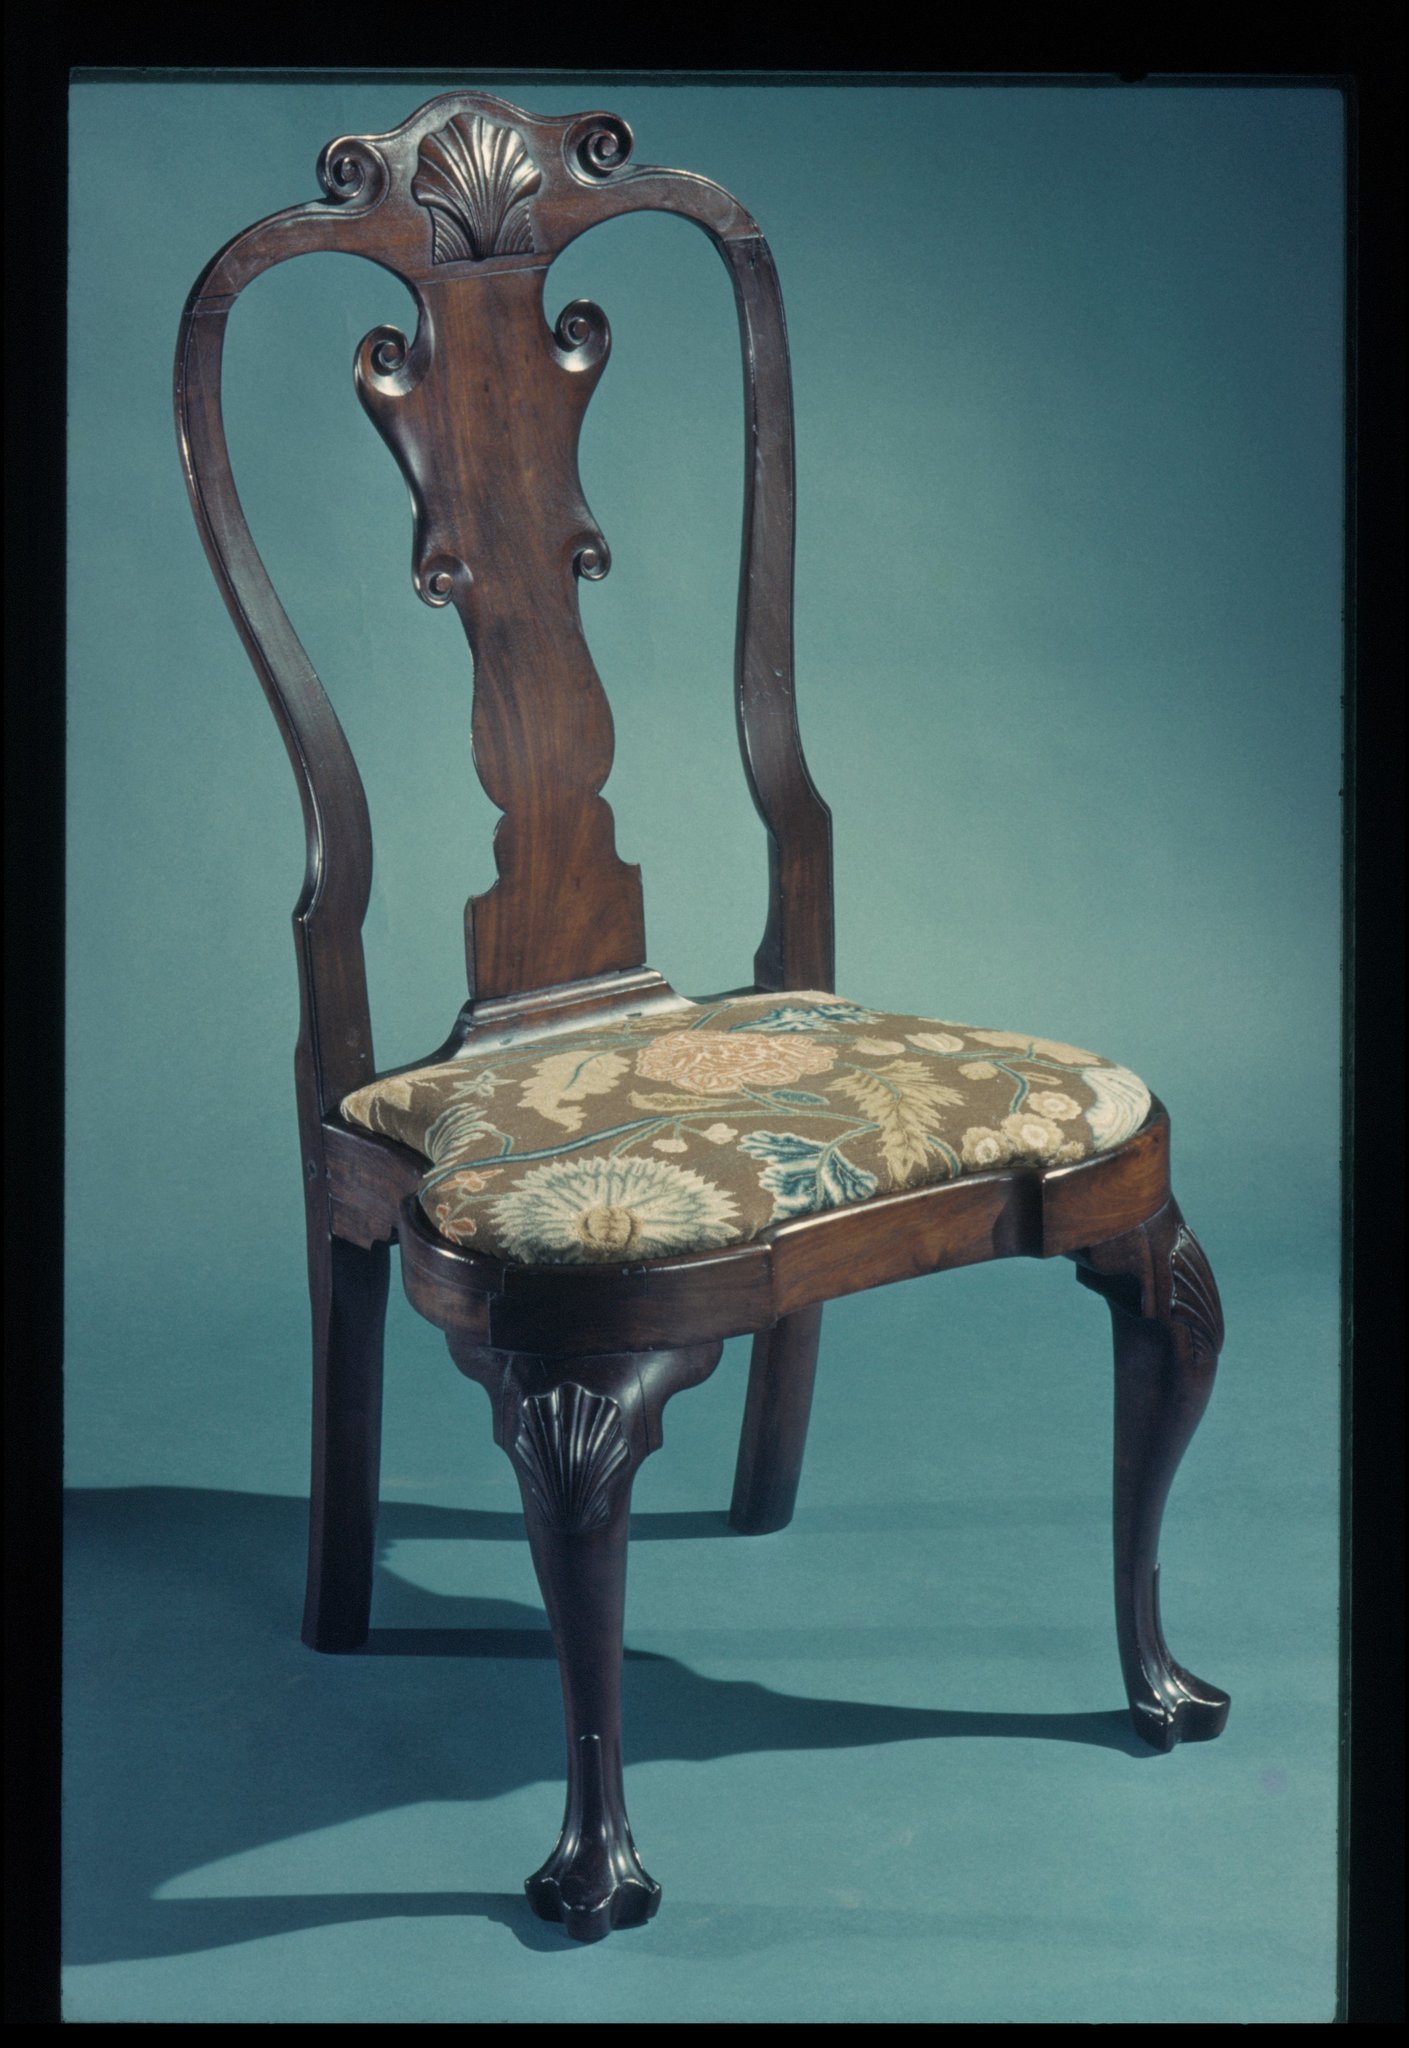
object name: side chair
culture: american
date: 1750-1775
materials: wood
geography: united states